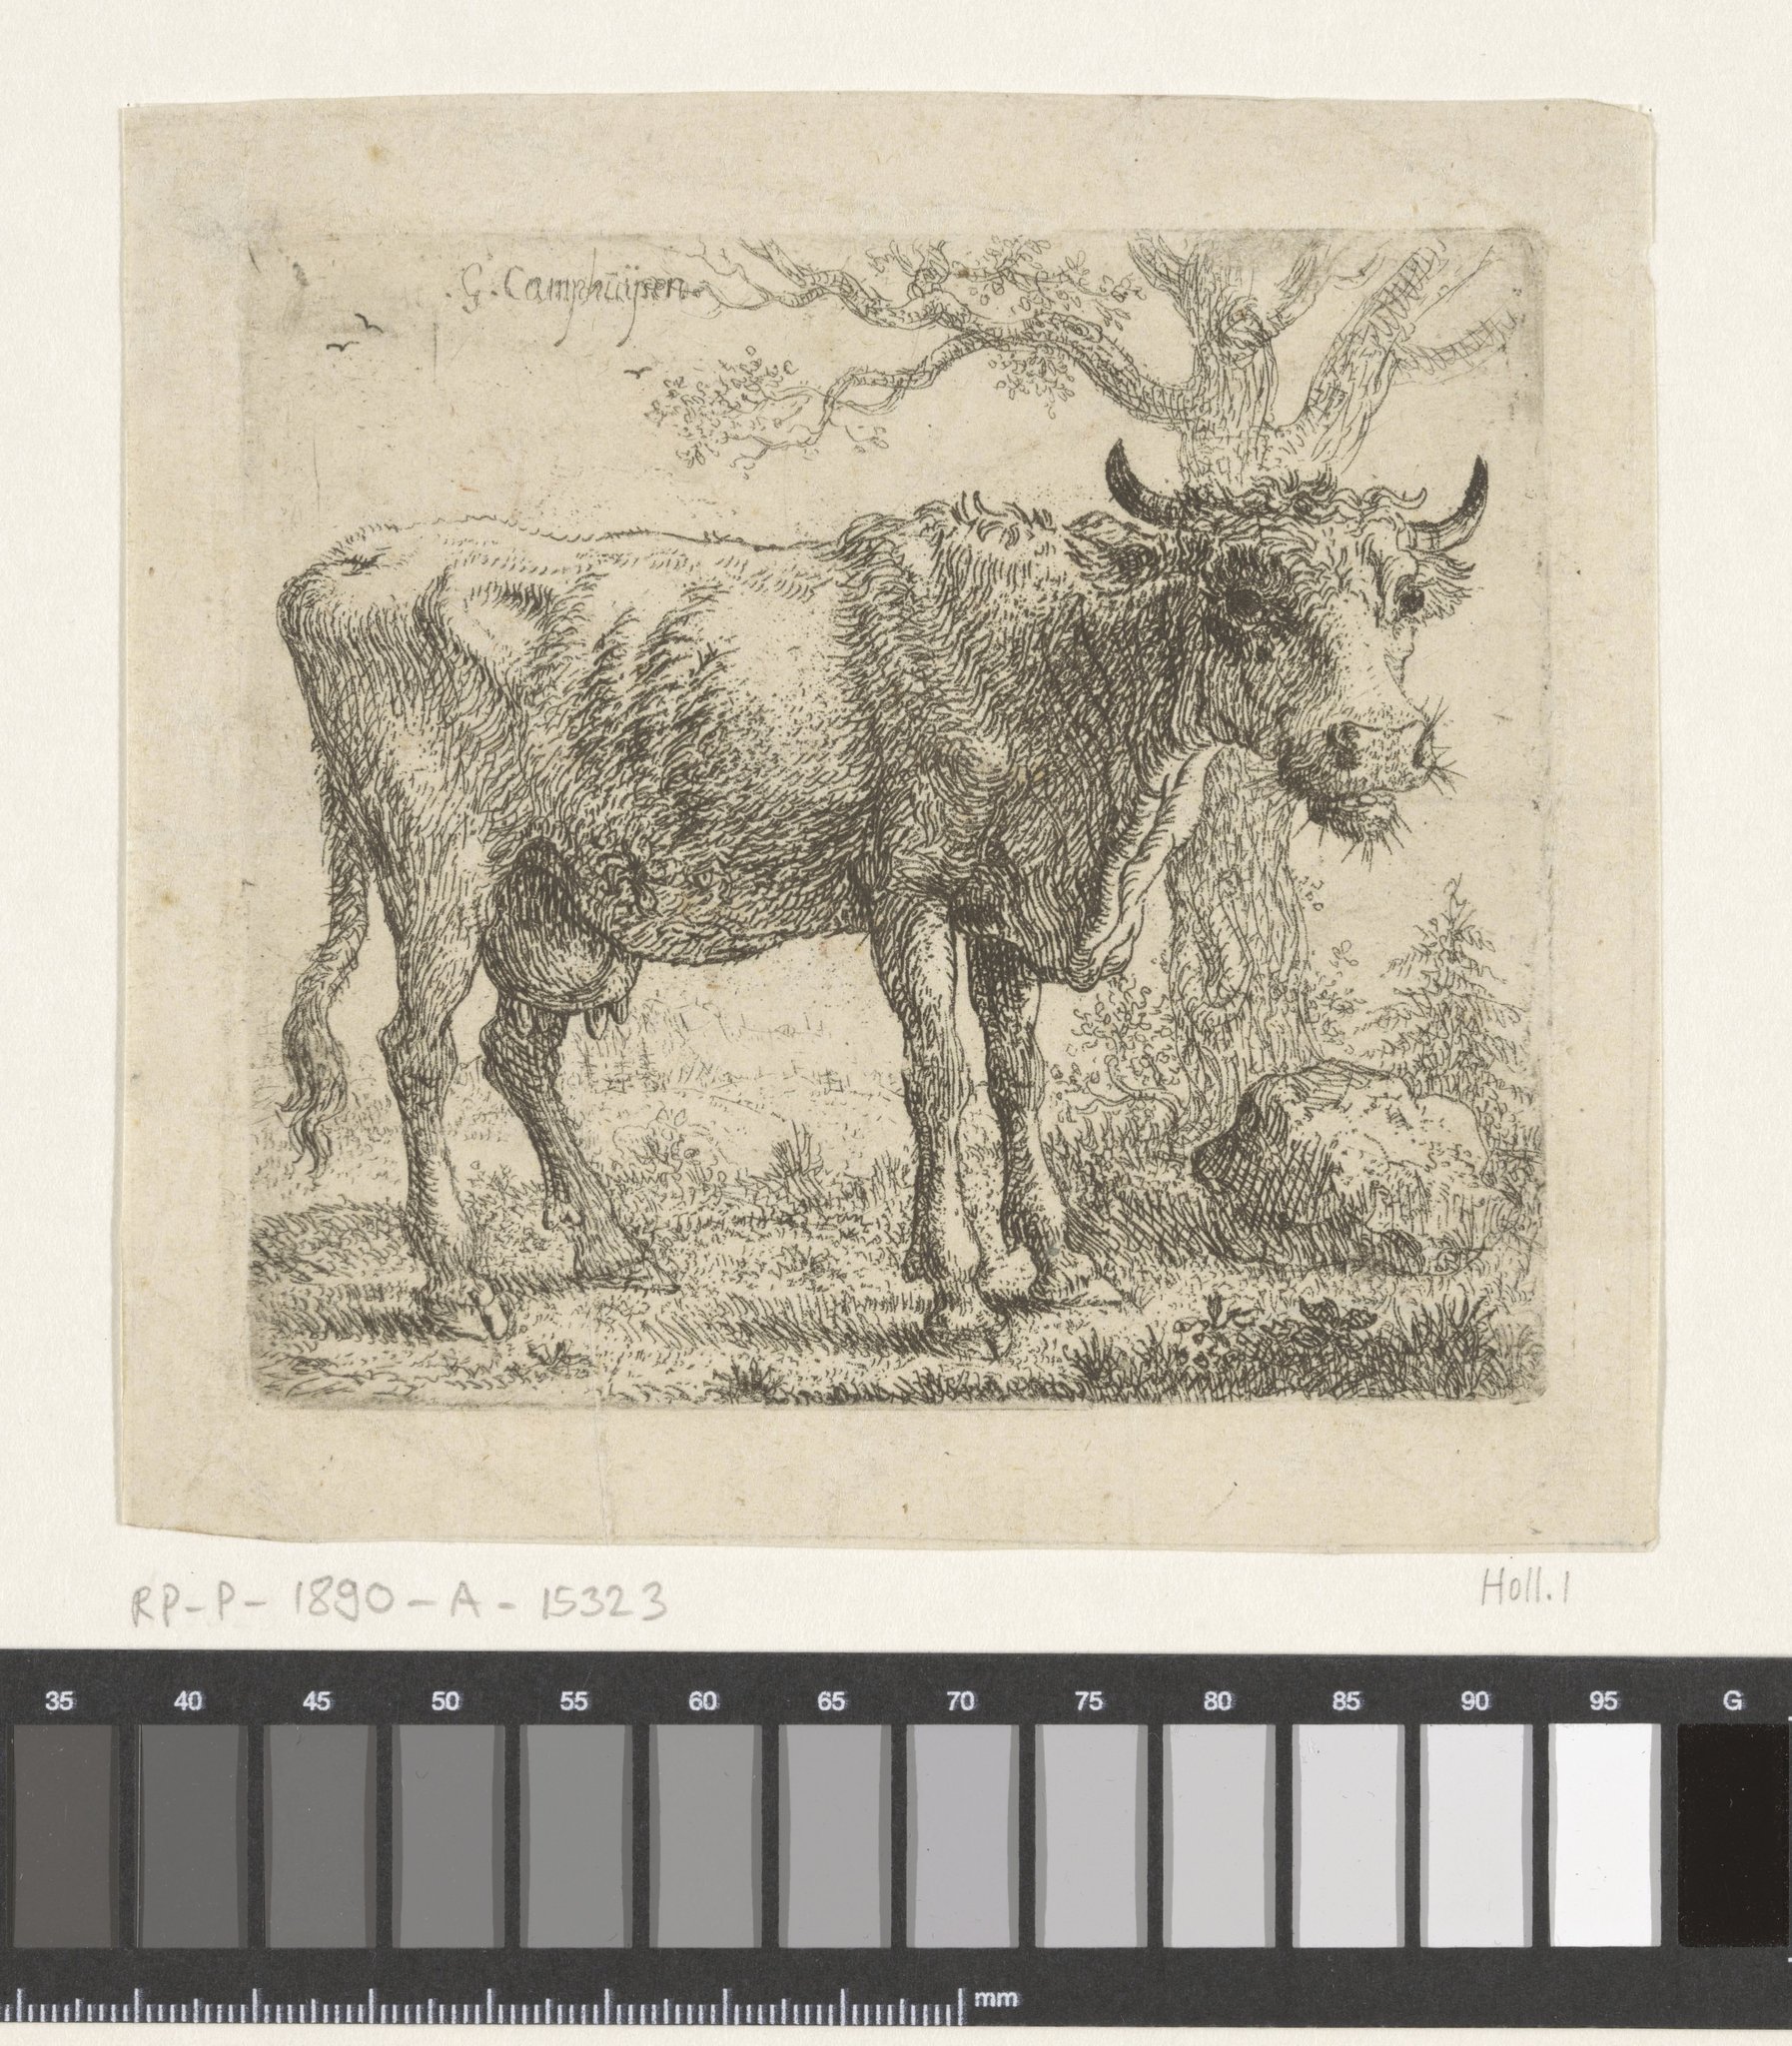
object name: print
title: Staande koe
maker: govert dircksz. camphuysen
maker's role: draughtsman, print maker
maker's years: 1623-1672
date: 1640-1672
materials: paper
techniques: etching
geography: amsterdam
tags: cow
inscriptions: collector's mark: Lugt 2228